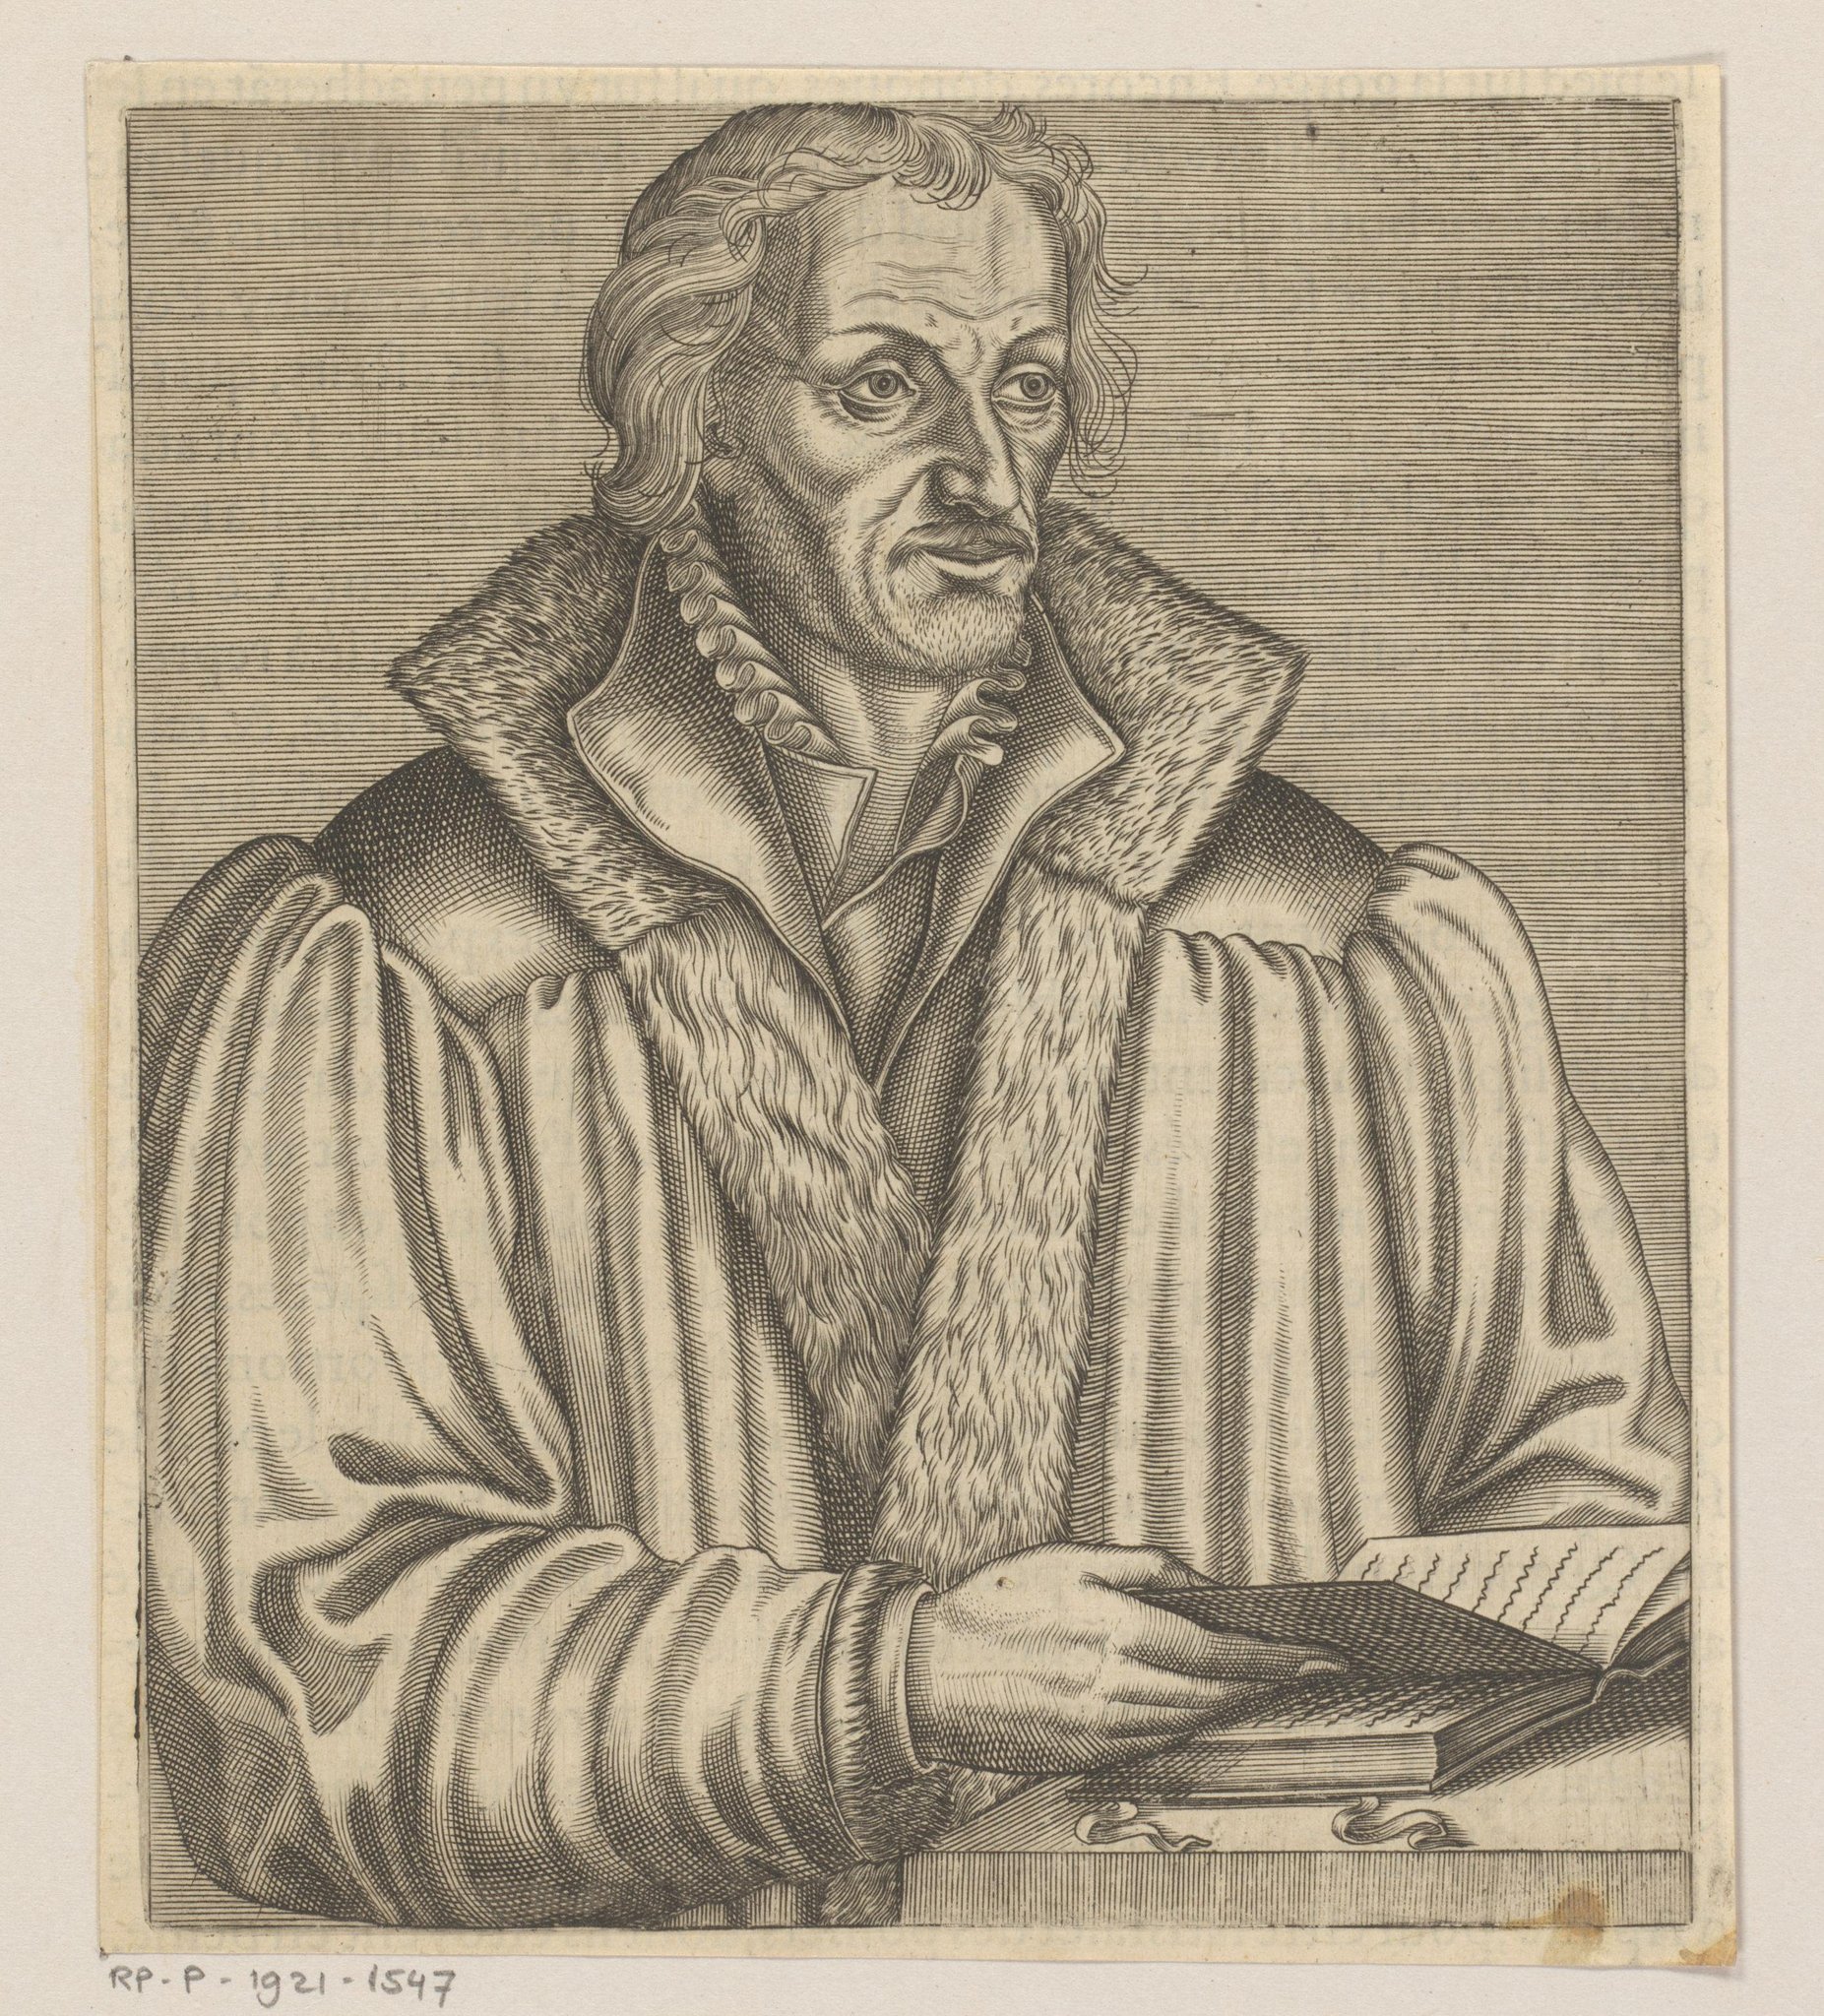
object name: book illustration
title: Portret van Philipp Melanchthon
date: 1584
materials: paper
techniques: engraving, etching, letterpress printing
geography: paris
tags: theologian, historical persons, book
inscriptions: collector's mark: Lugt 2233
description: Prent uit: Thevet, André. Les vrais pourtraits et vies des hommes illustres grecz, latins et payens (...). Parijs: weduwe Jacques Kerver en Guillaume Chaudière, 1584, dl. 2, f. 575.